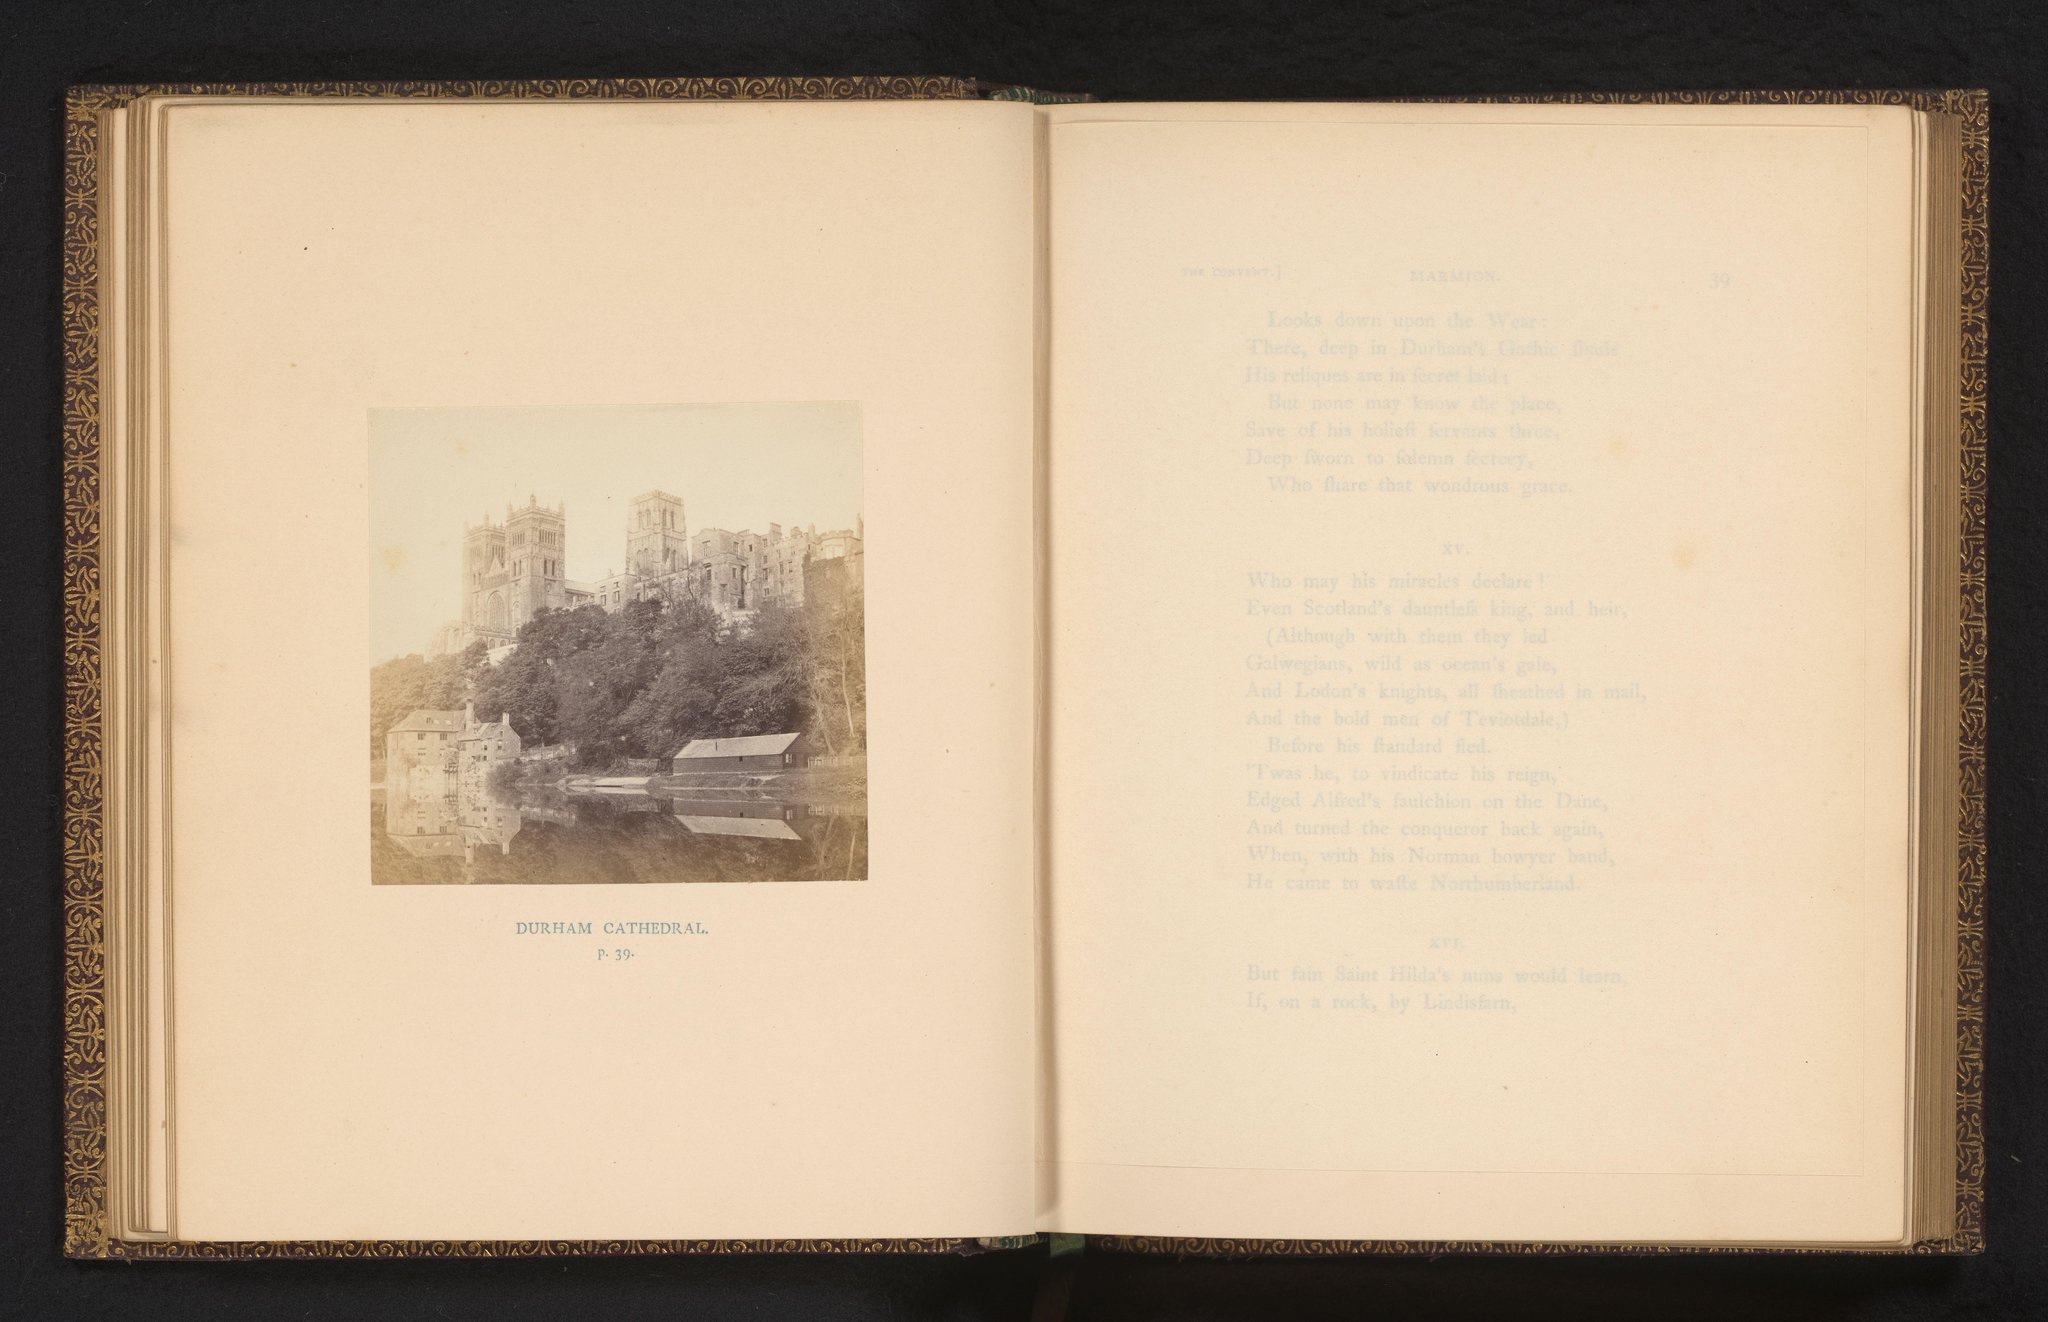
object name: photograph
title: Gezicht op de kathedraal van Durham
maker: thomas annan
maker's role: fotograaf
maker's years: 1829-1887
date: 1861-1866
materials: paper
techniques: albumen print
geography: durham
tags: church (exterior)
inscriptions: inscription: ‘p. 39.’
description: Foto op ongenummerde pagina tegenover pagina 39.